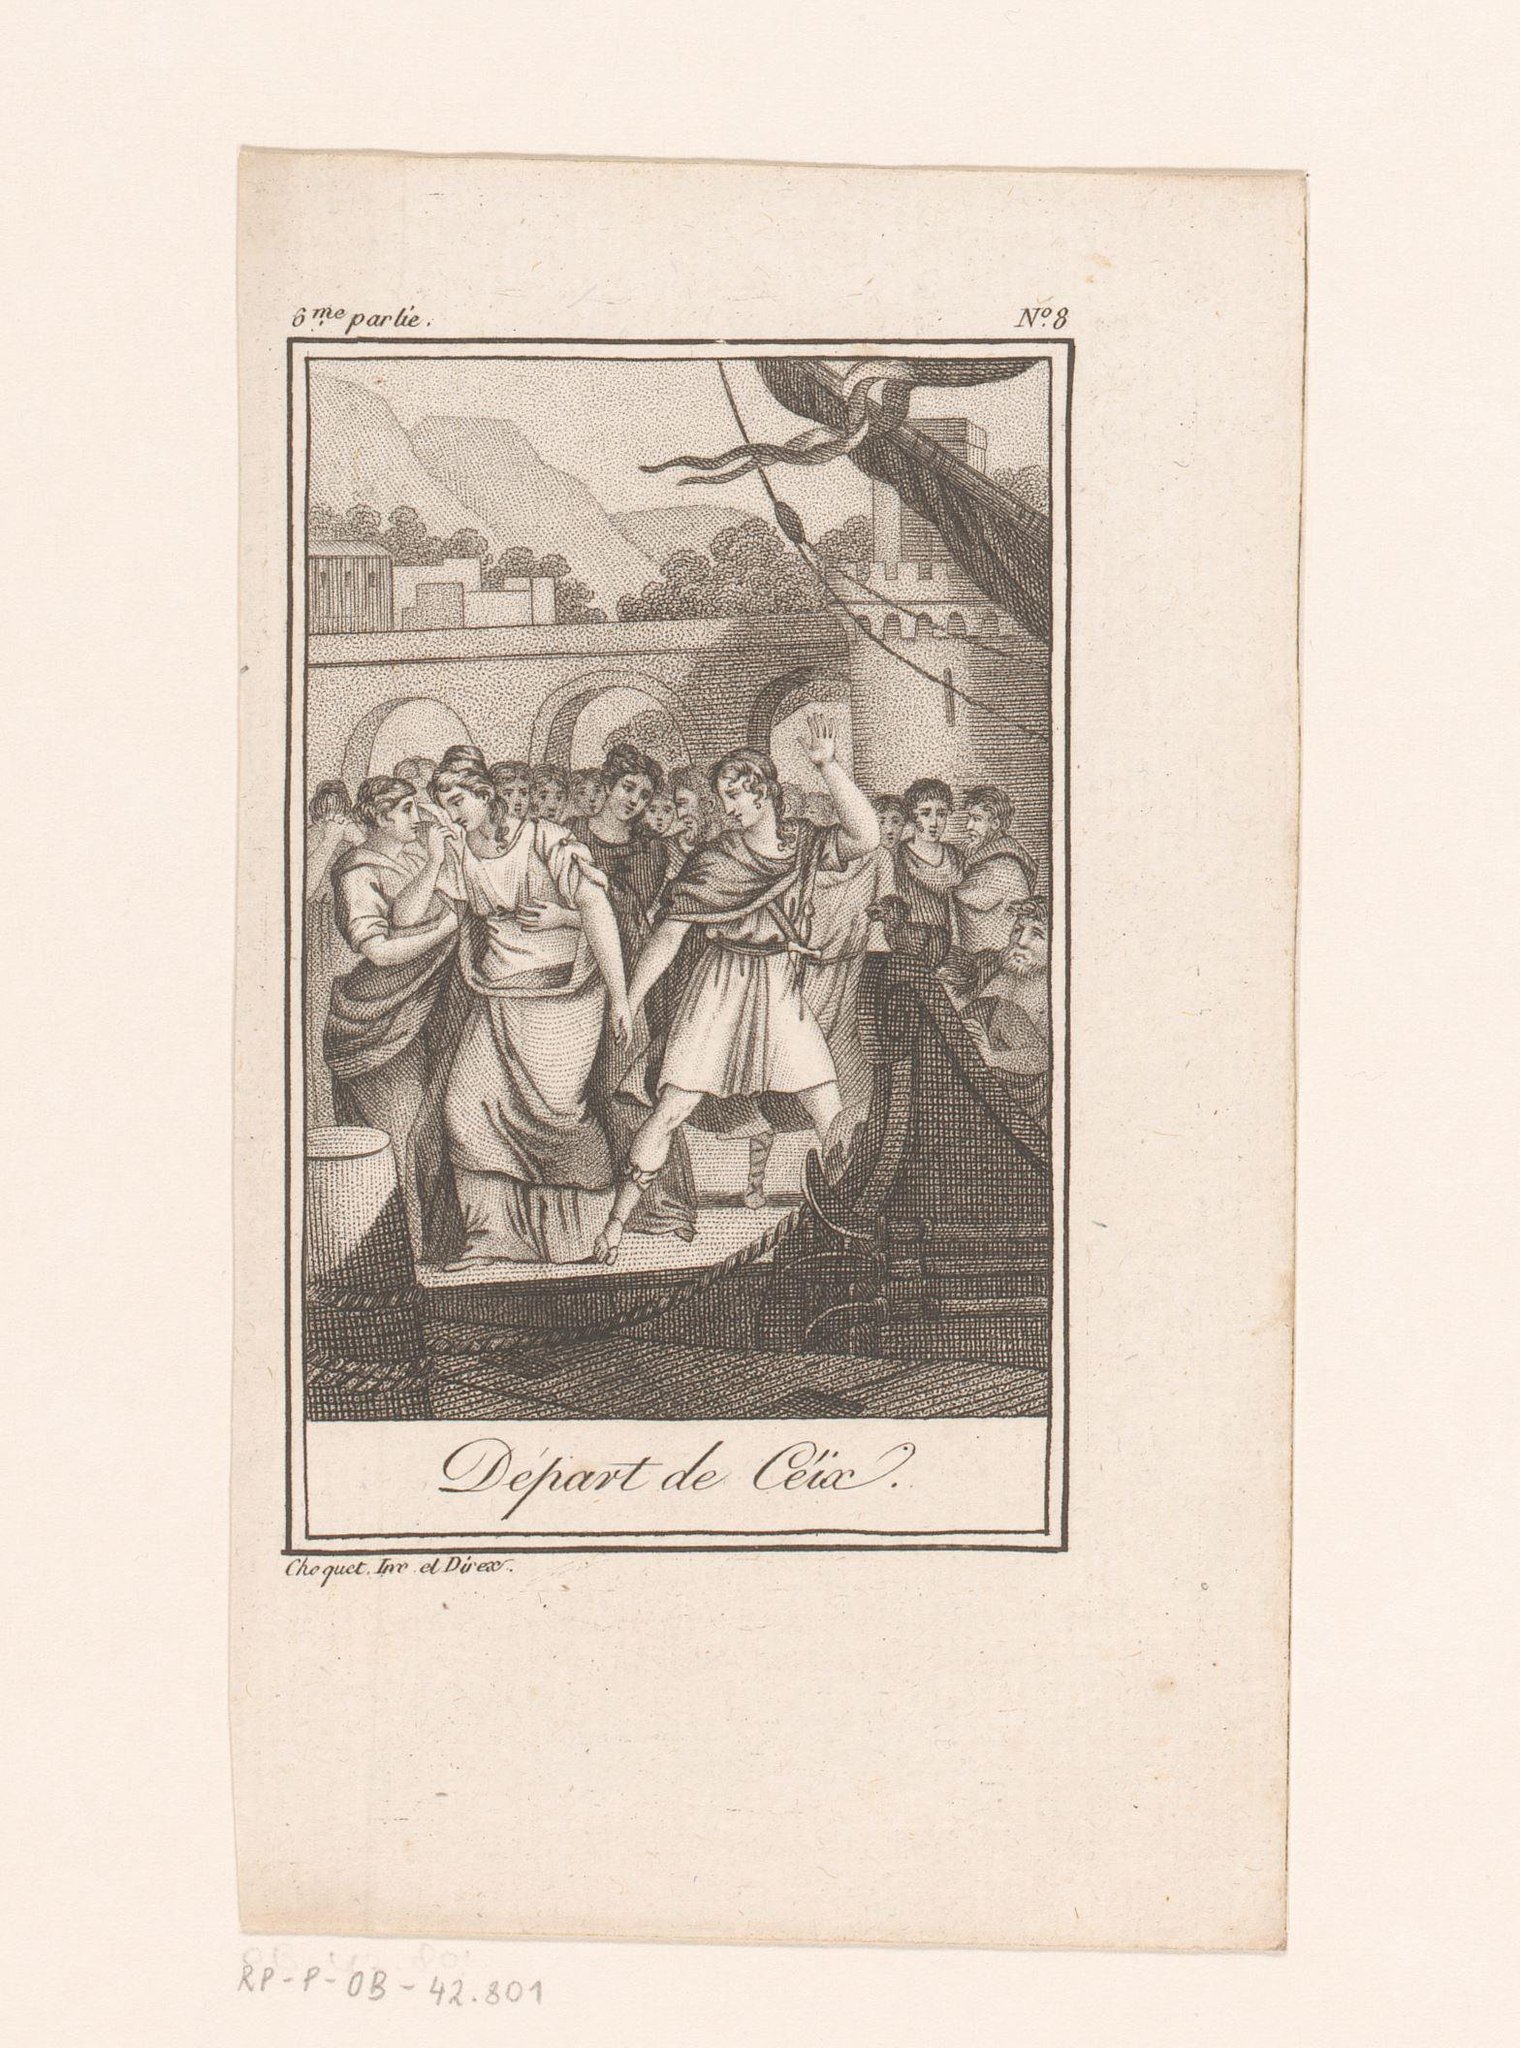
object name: print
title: Mythologische scènes onder supervisie van Choquet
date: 1784-1824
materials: paper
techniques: engraving, etching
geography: france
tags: alcyone bids ceyx farewell and stares at the departing ship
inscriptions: collector's mark: Lugt 2228